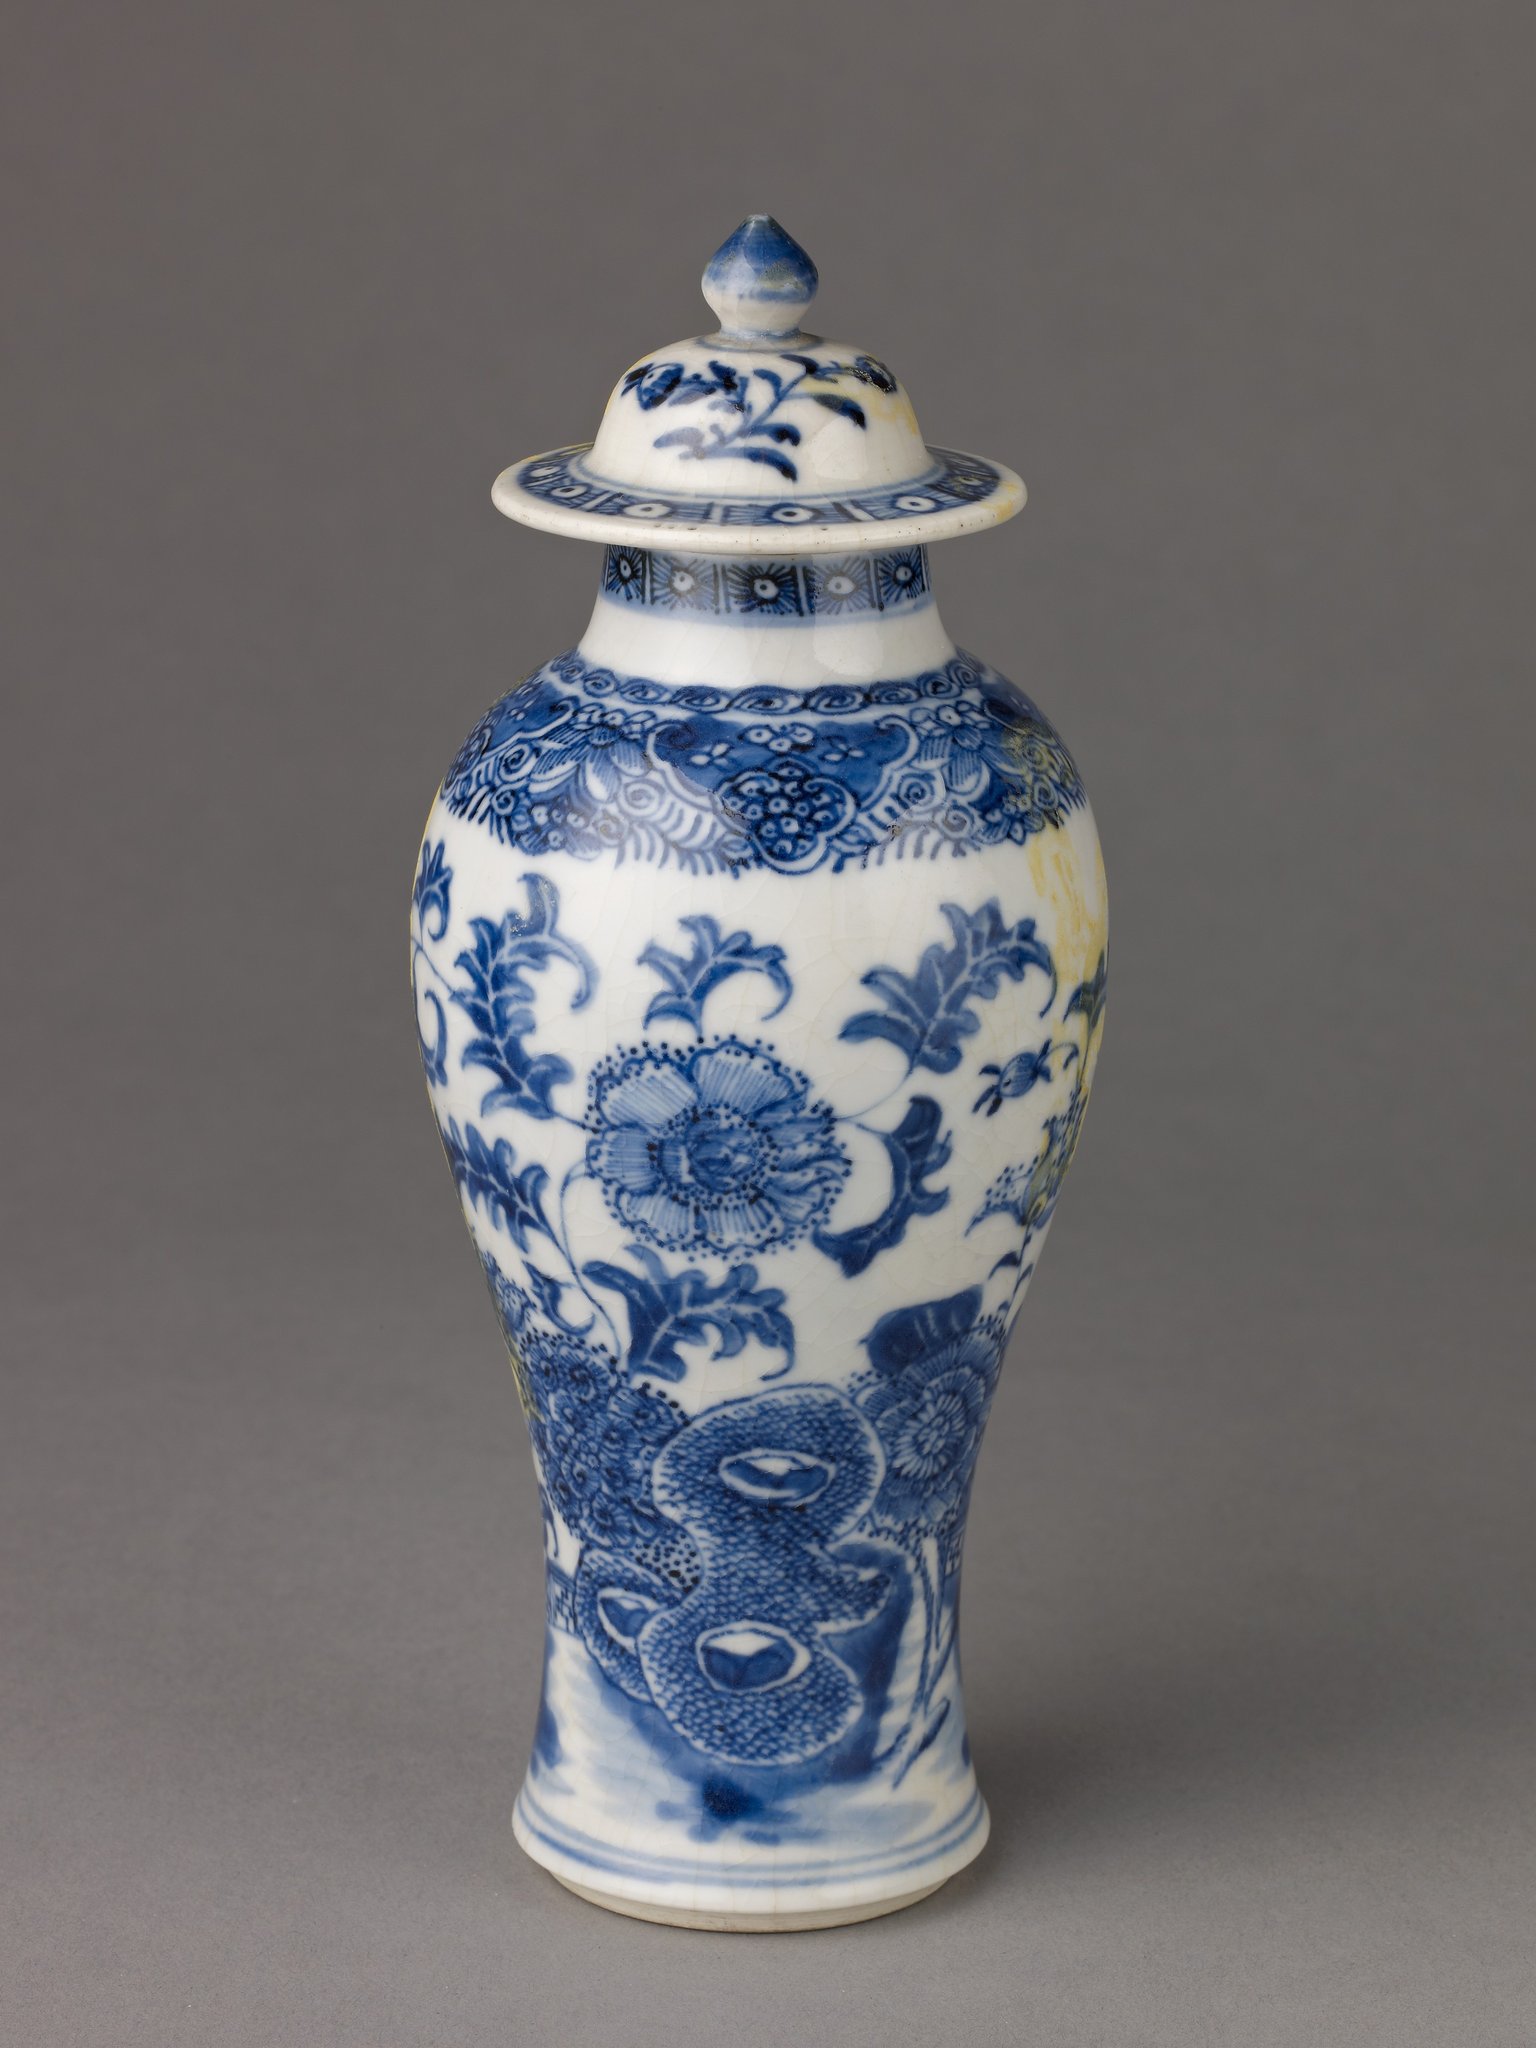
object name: covered vase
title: Small covered vase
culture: chinese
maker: chinese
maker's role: artist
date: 1767-1800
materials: paste, porcelain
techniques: painting, underglaze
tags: flowers